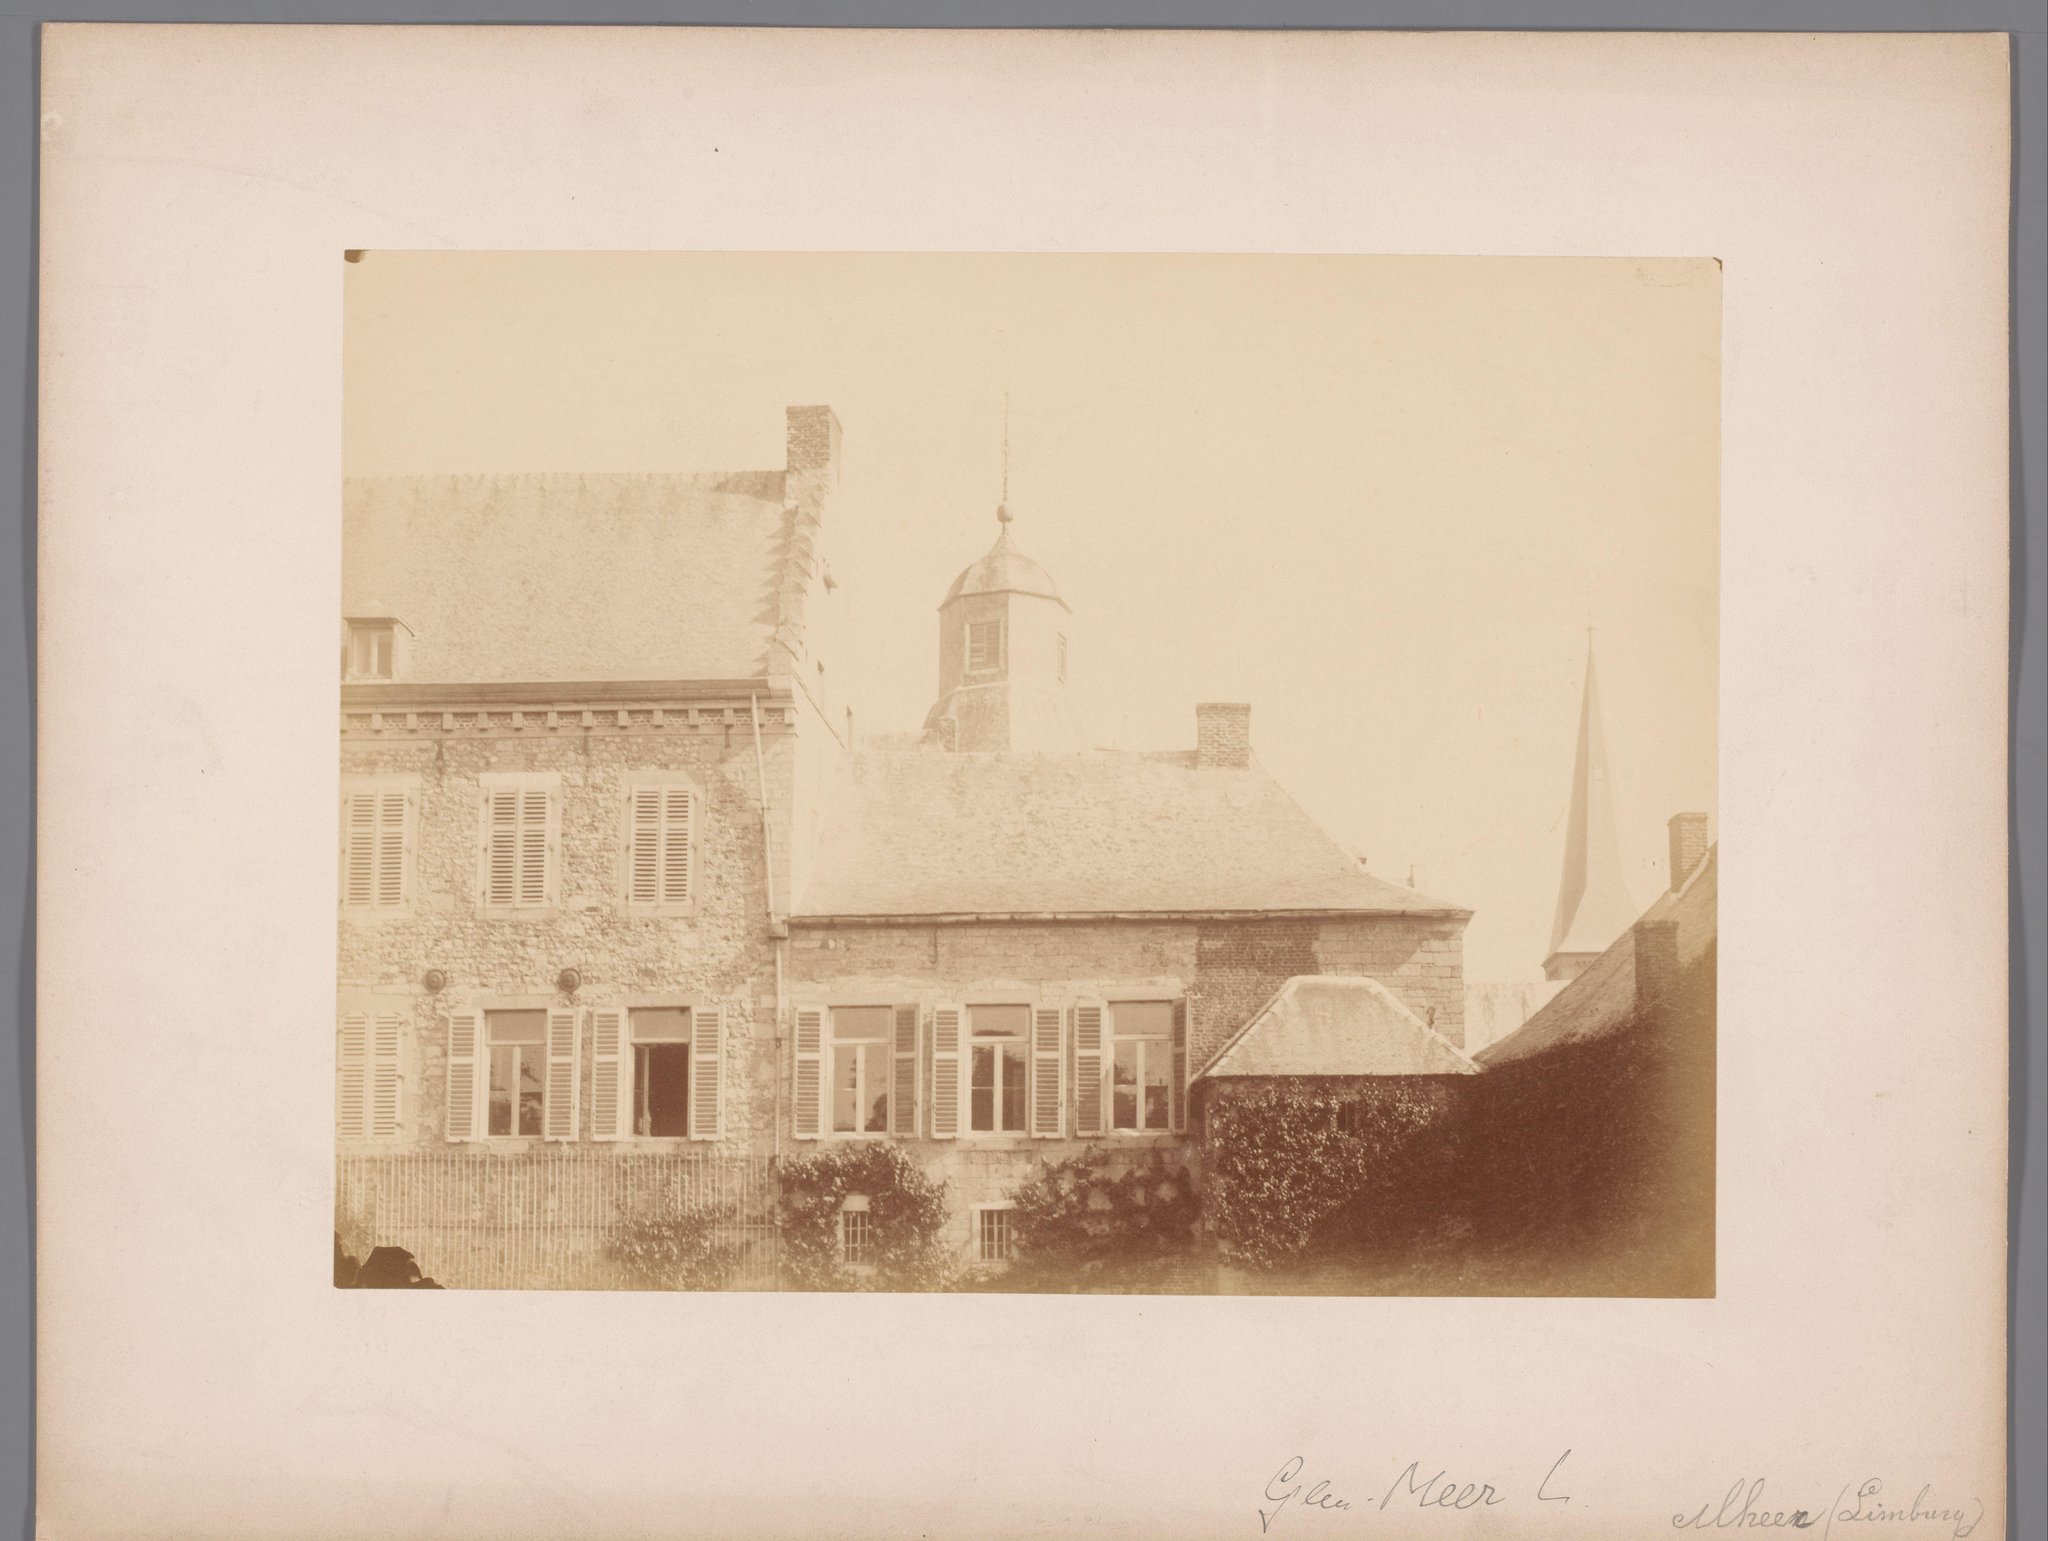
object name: photograph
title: Gedeelte van het Kasteel van Mheer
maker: anoniem (monumentenzorg)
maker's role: fotograaf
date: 1890-1920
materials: cardboard, photographic support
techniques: albumen print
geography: limburg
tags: castle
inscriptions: annotation: ‘Mheer (Limburg)/ Kasteel & boerderij/ Aangezicht kasteel’, annotation: ‘Gem. Meer. L/ Mheer (Limburg)’